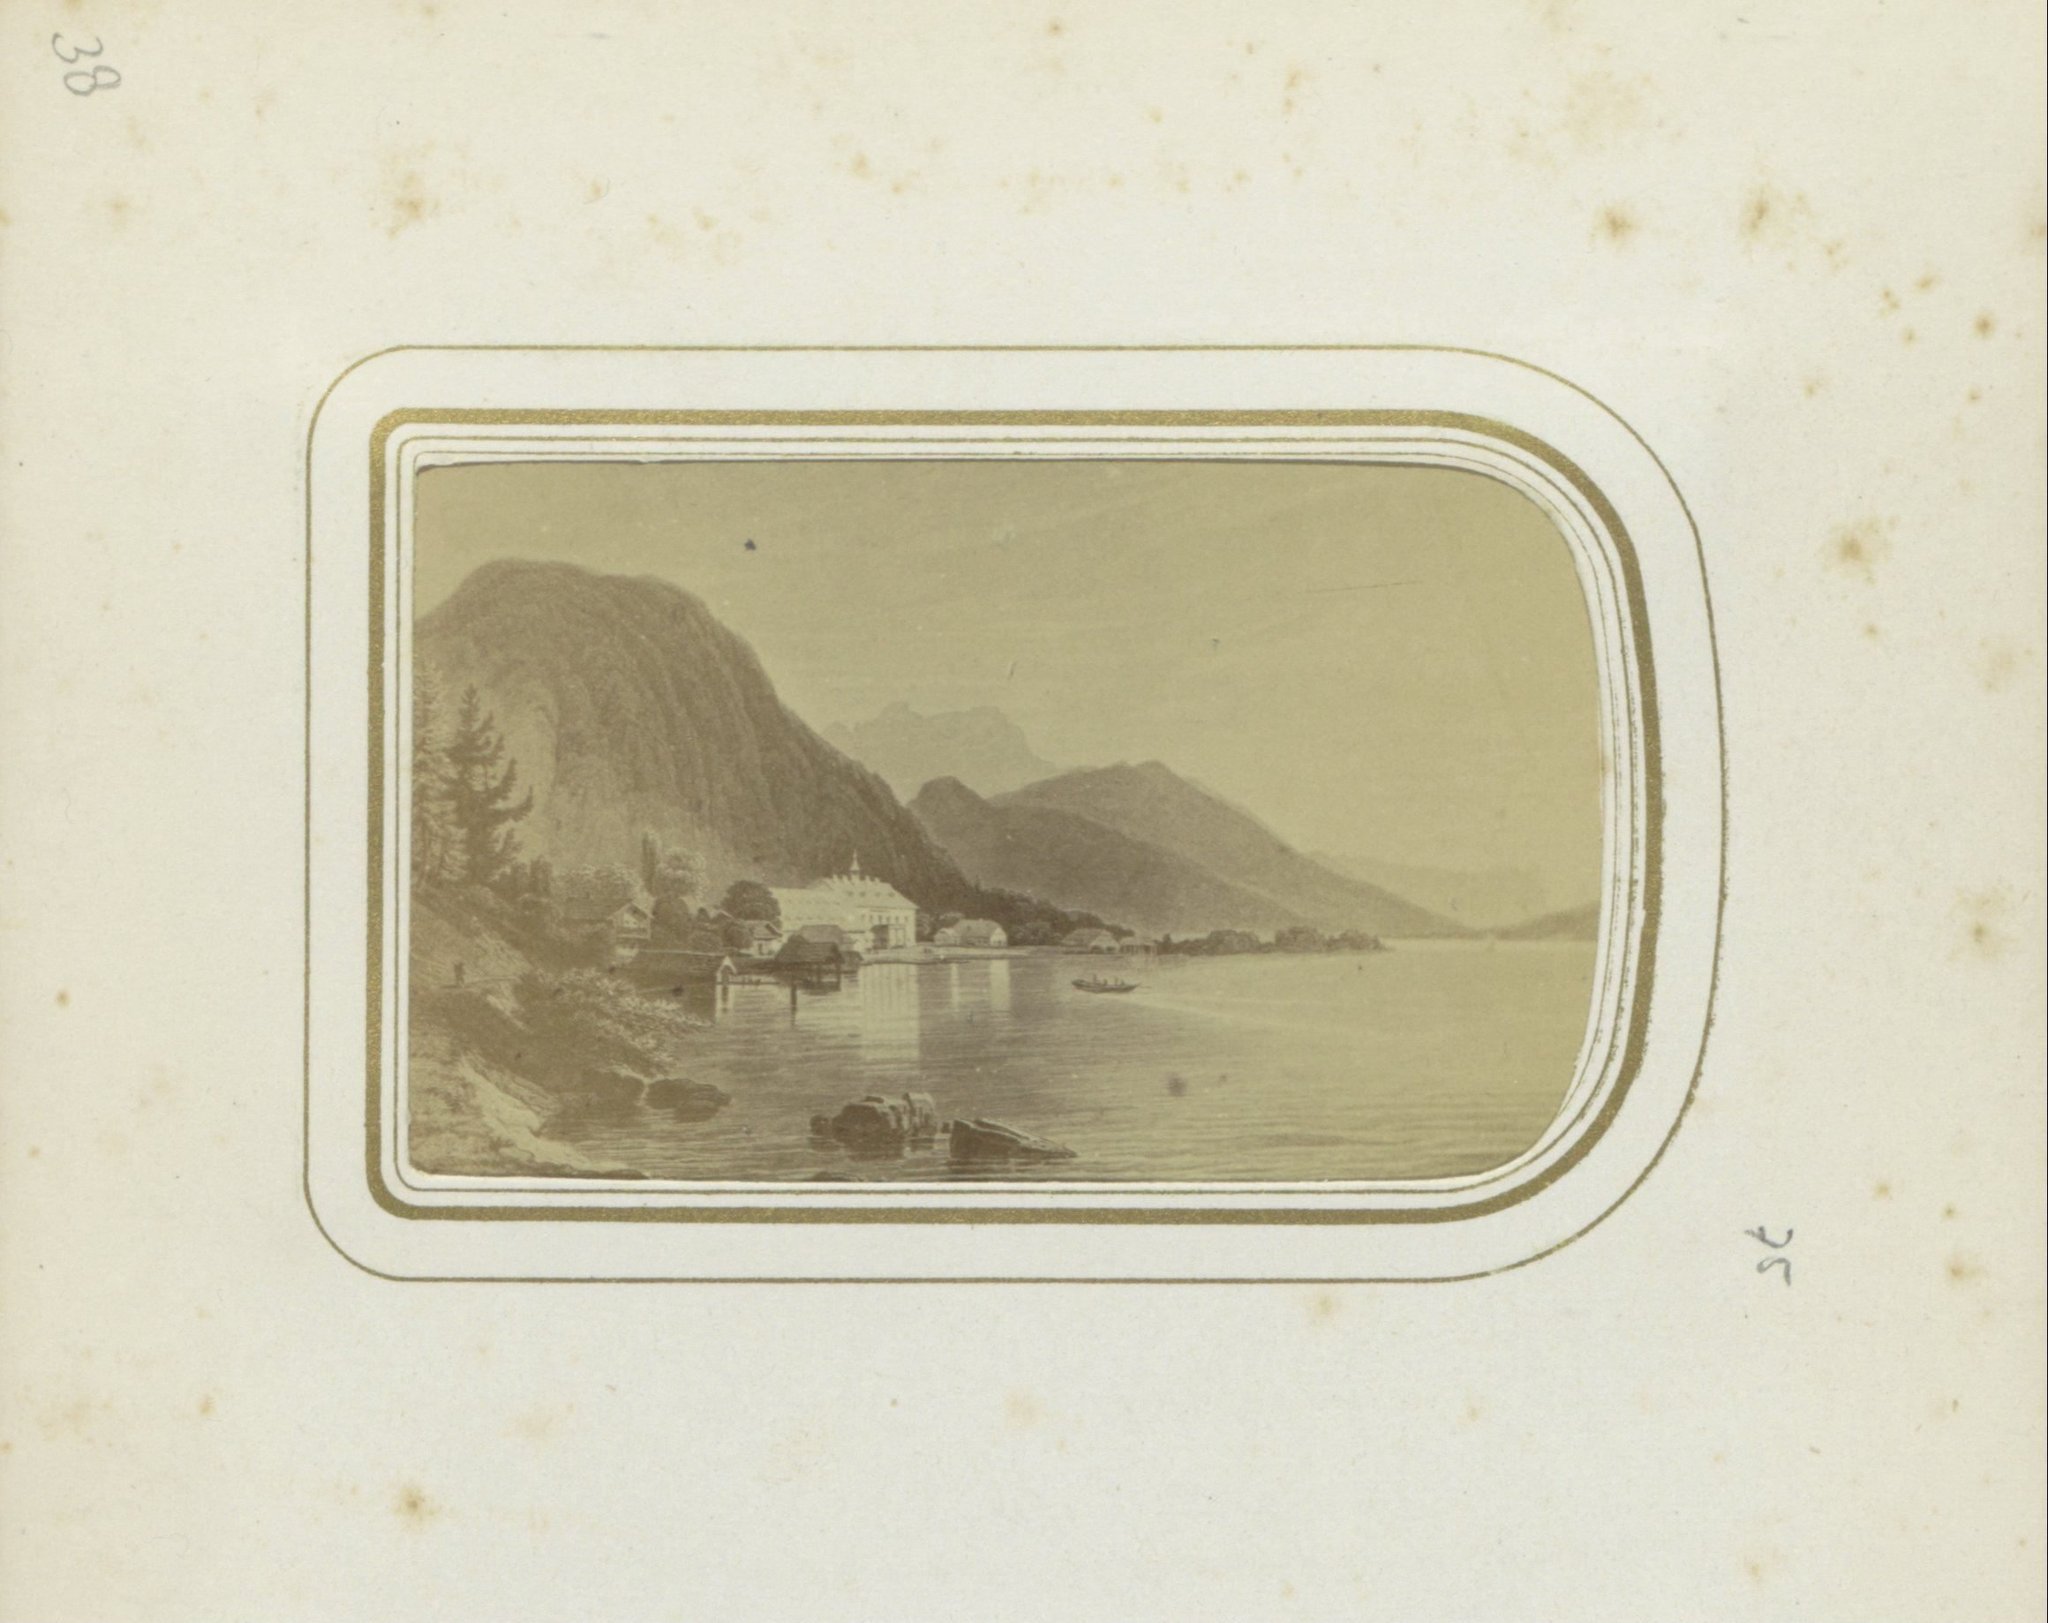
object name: photograph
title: Fotoreproductie van (vermoedelijk) een prent van Weissenbach aan de Attersee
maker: Anonymous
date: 1865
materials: paper, photographic support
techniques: albumen print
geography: weissenbach am attersee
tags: lake, travelling; tourism, mountains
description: Onderdeel van Fotoalbum van een reis door Zwitserland, Oostenrijk en Duitsland door de Nederlandse familie Derkinderen.